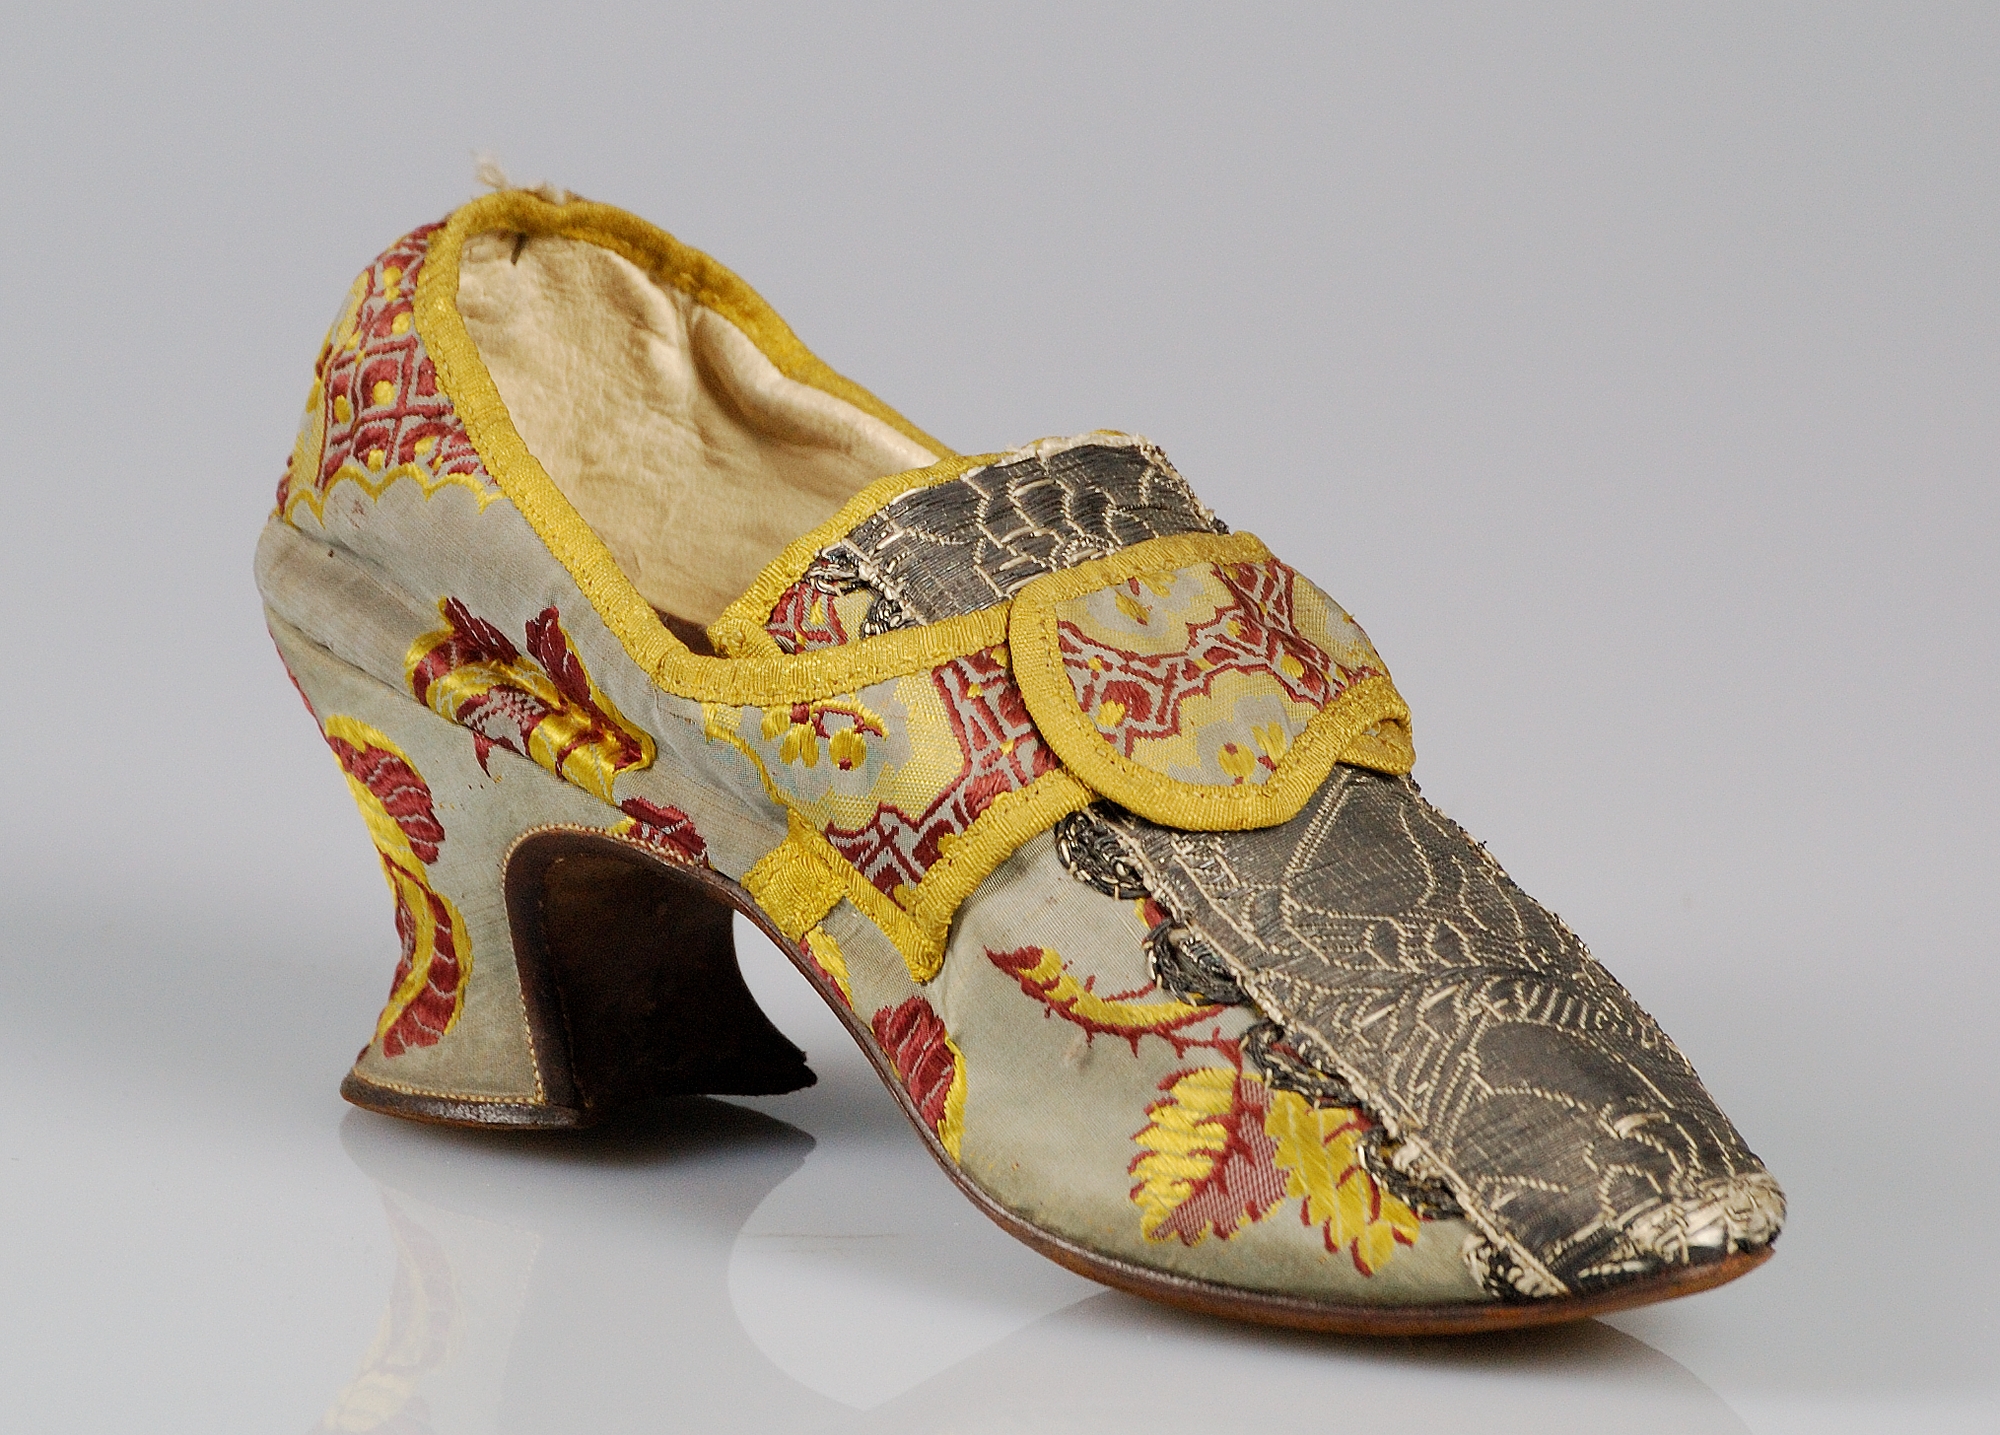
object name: shoe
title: Shoes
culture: british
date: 1760-1780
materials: silk